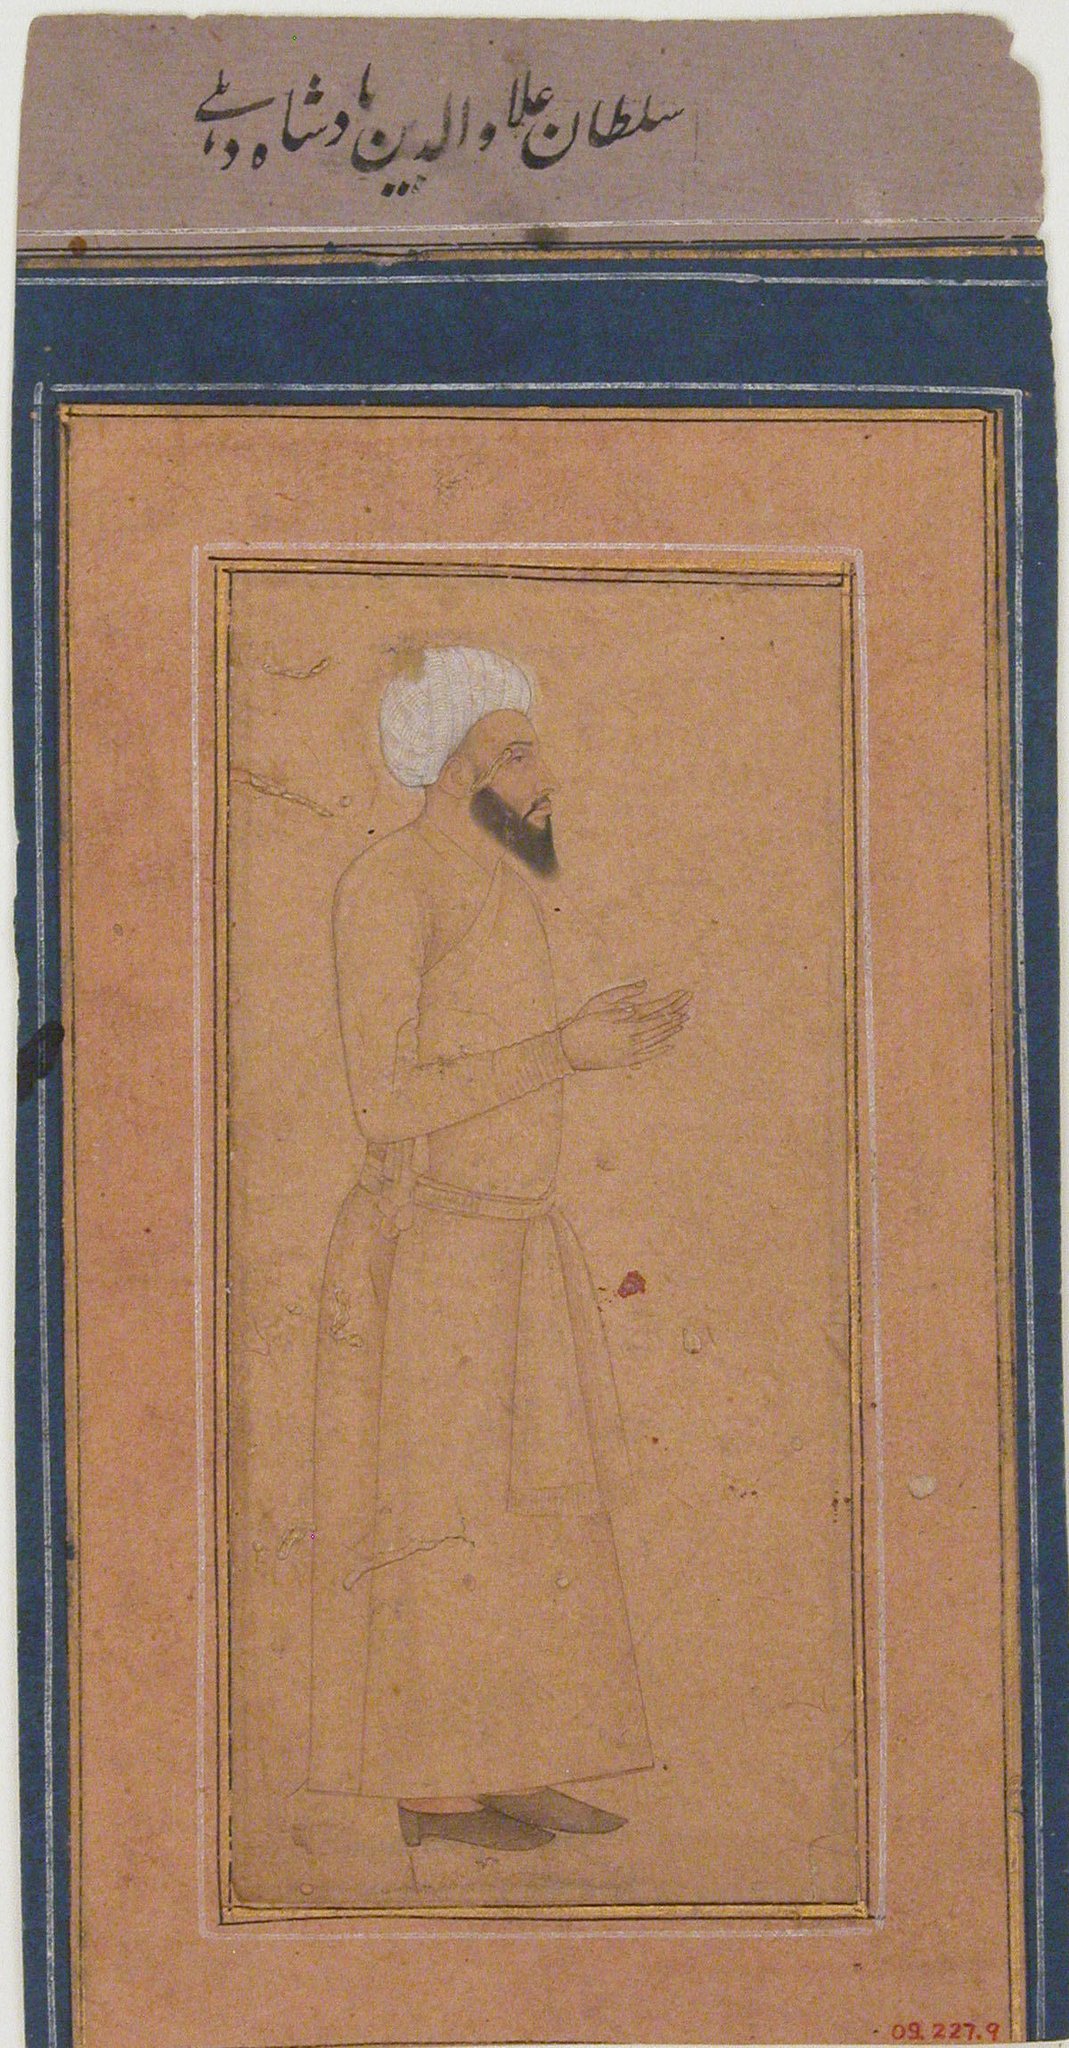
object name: illustrated album leaf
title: Portrait of Sultan 'Ala-ud-Din, Padshah of Delhi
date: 1667-1700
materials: gold, ink, paper, watercolor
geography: india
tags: men,portraits,profiles